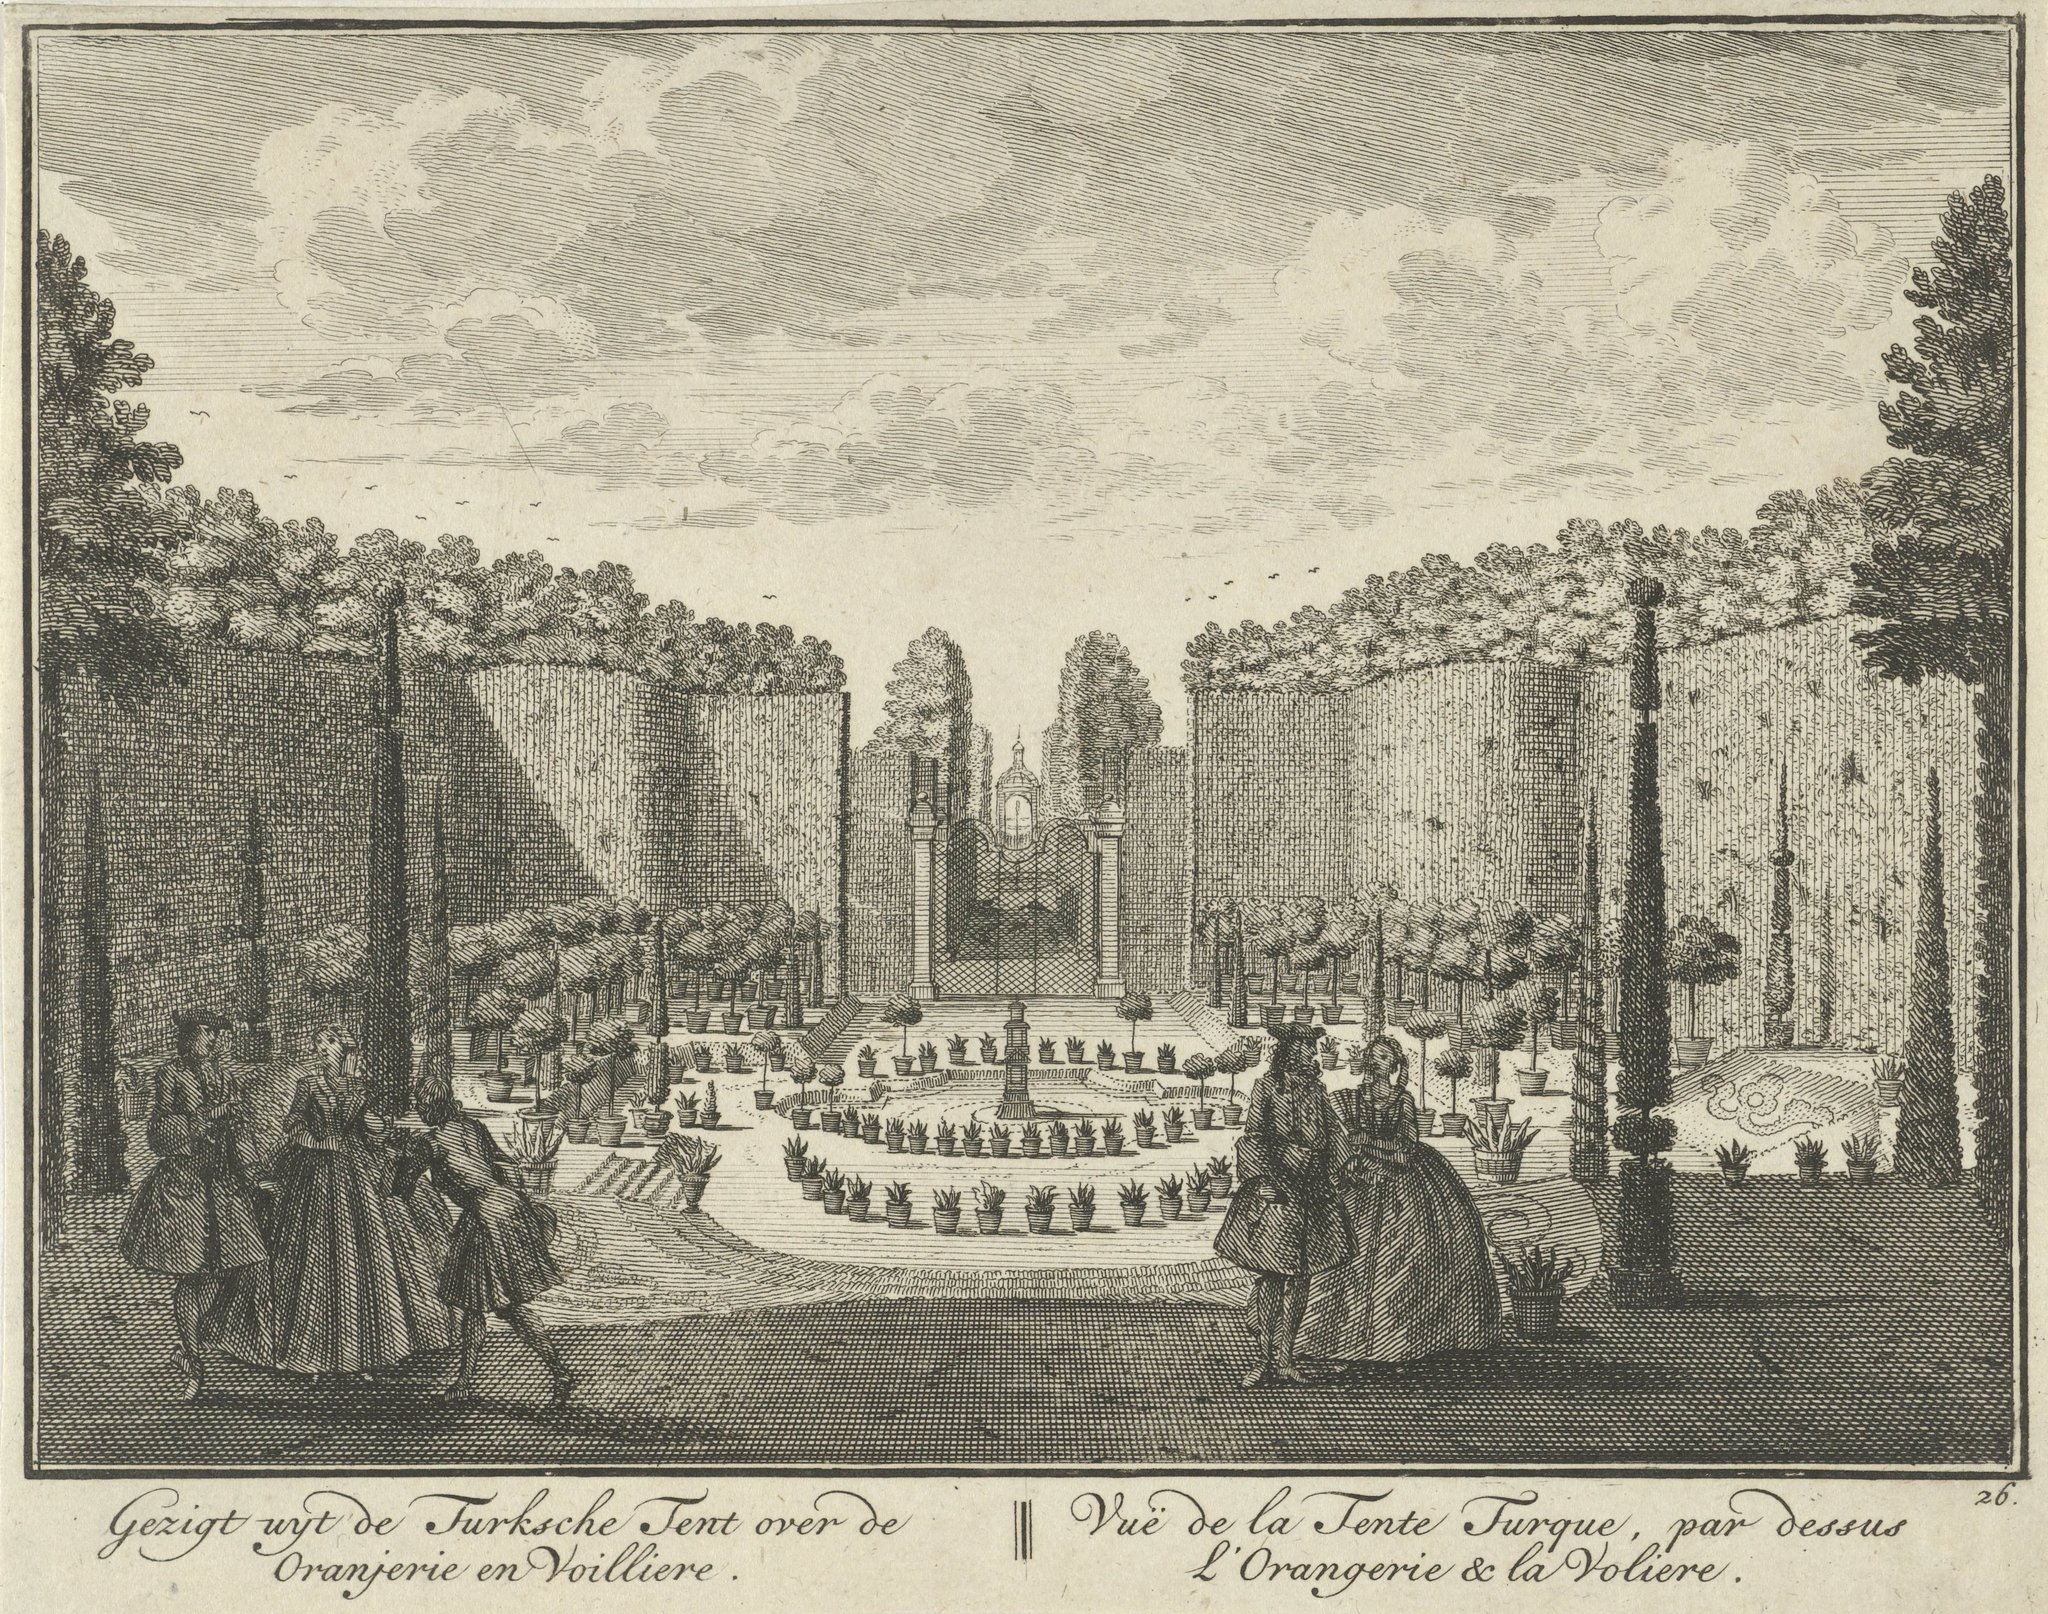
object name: print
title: Het Oud Adelyk huys en Ridderhofstad Ter Meer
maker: hendrik de leth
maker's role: draughtsman, print maker, publisher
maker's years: 1703-1766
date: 1740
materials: paper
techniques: etching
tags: birds in a large cage, aviary, french or architectonic garden; formal garden, greenhouse, orangery, country-house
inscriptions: collector's mark: Lugt 2228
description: Gezicht vanuit de Turkse Tent op de oranjerie en de volière in de Franse tuin van Huis ter Meer. Op de voorgrond staan links en rechts groepjes converserende figuren. De prent maakt deel uit van een serie met 26 gezichten op Huis ter Meer en het bijbehorende landgoed te Maarssen.